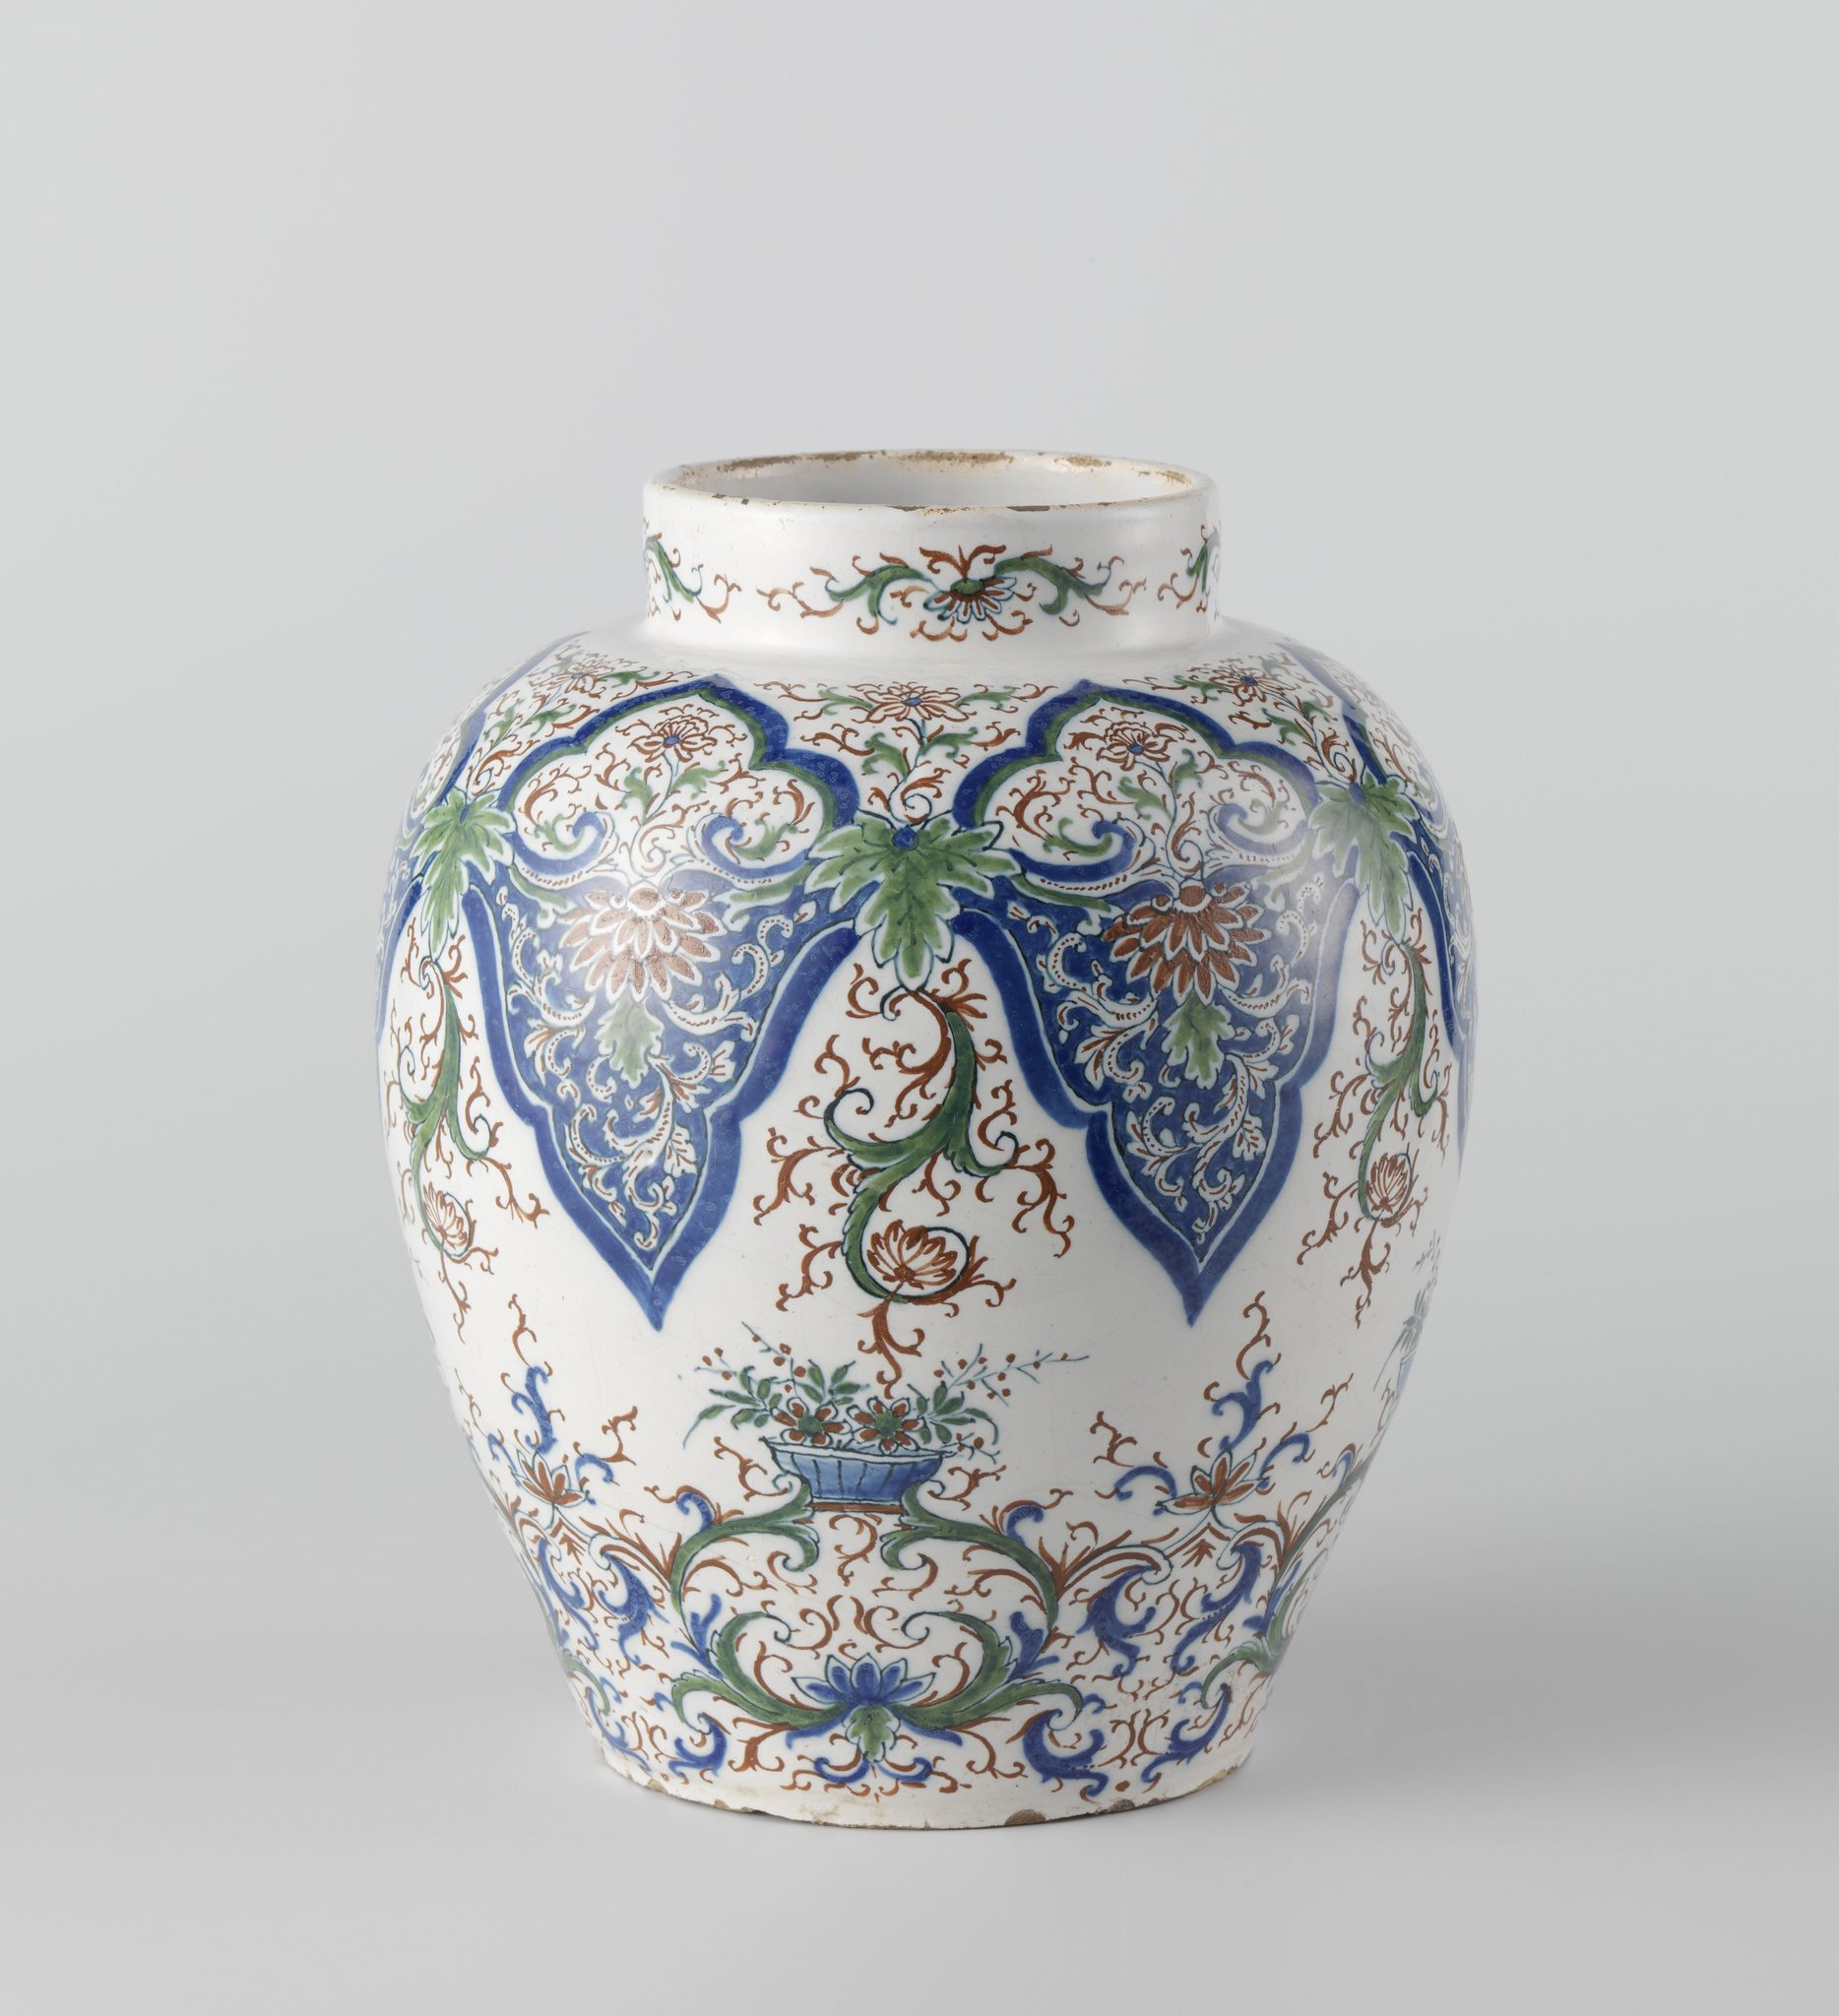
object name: covered jar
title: Pot (zonder deksel) van faience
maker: Anonymous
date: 1695-1720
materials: faience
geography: delft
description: Pot (zonder deksel) van faience. Veelkleurig beschilderd met lambrequins en bloemdecoraties.